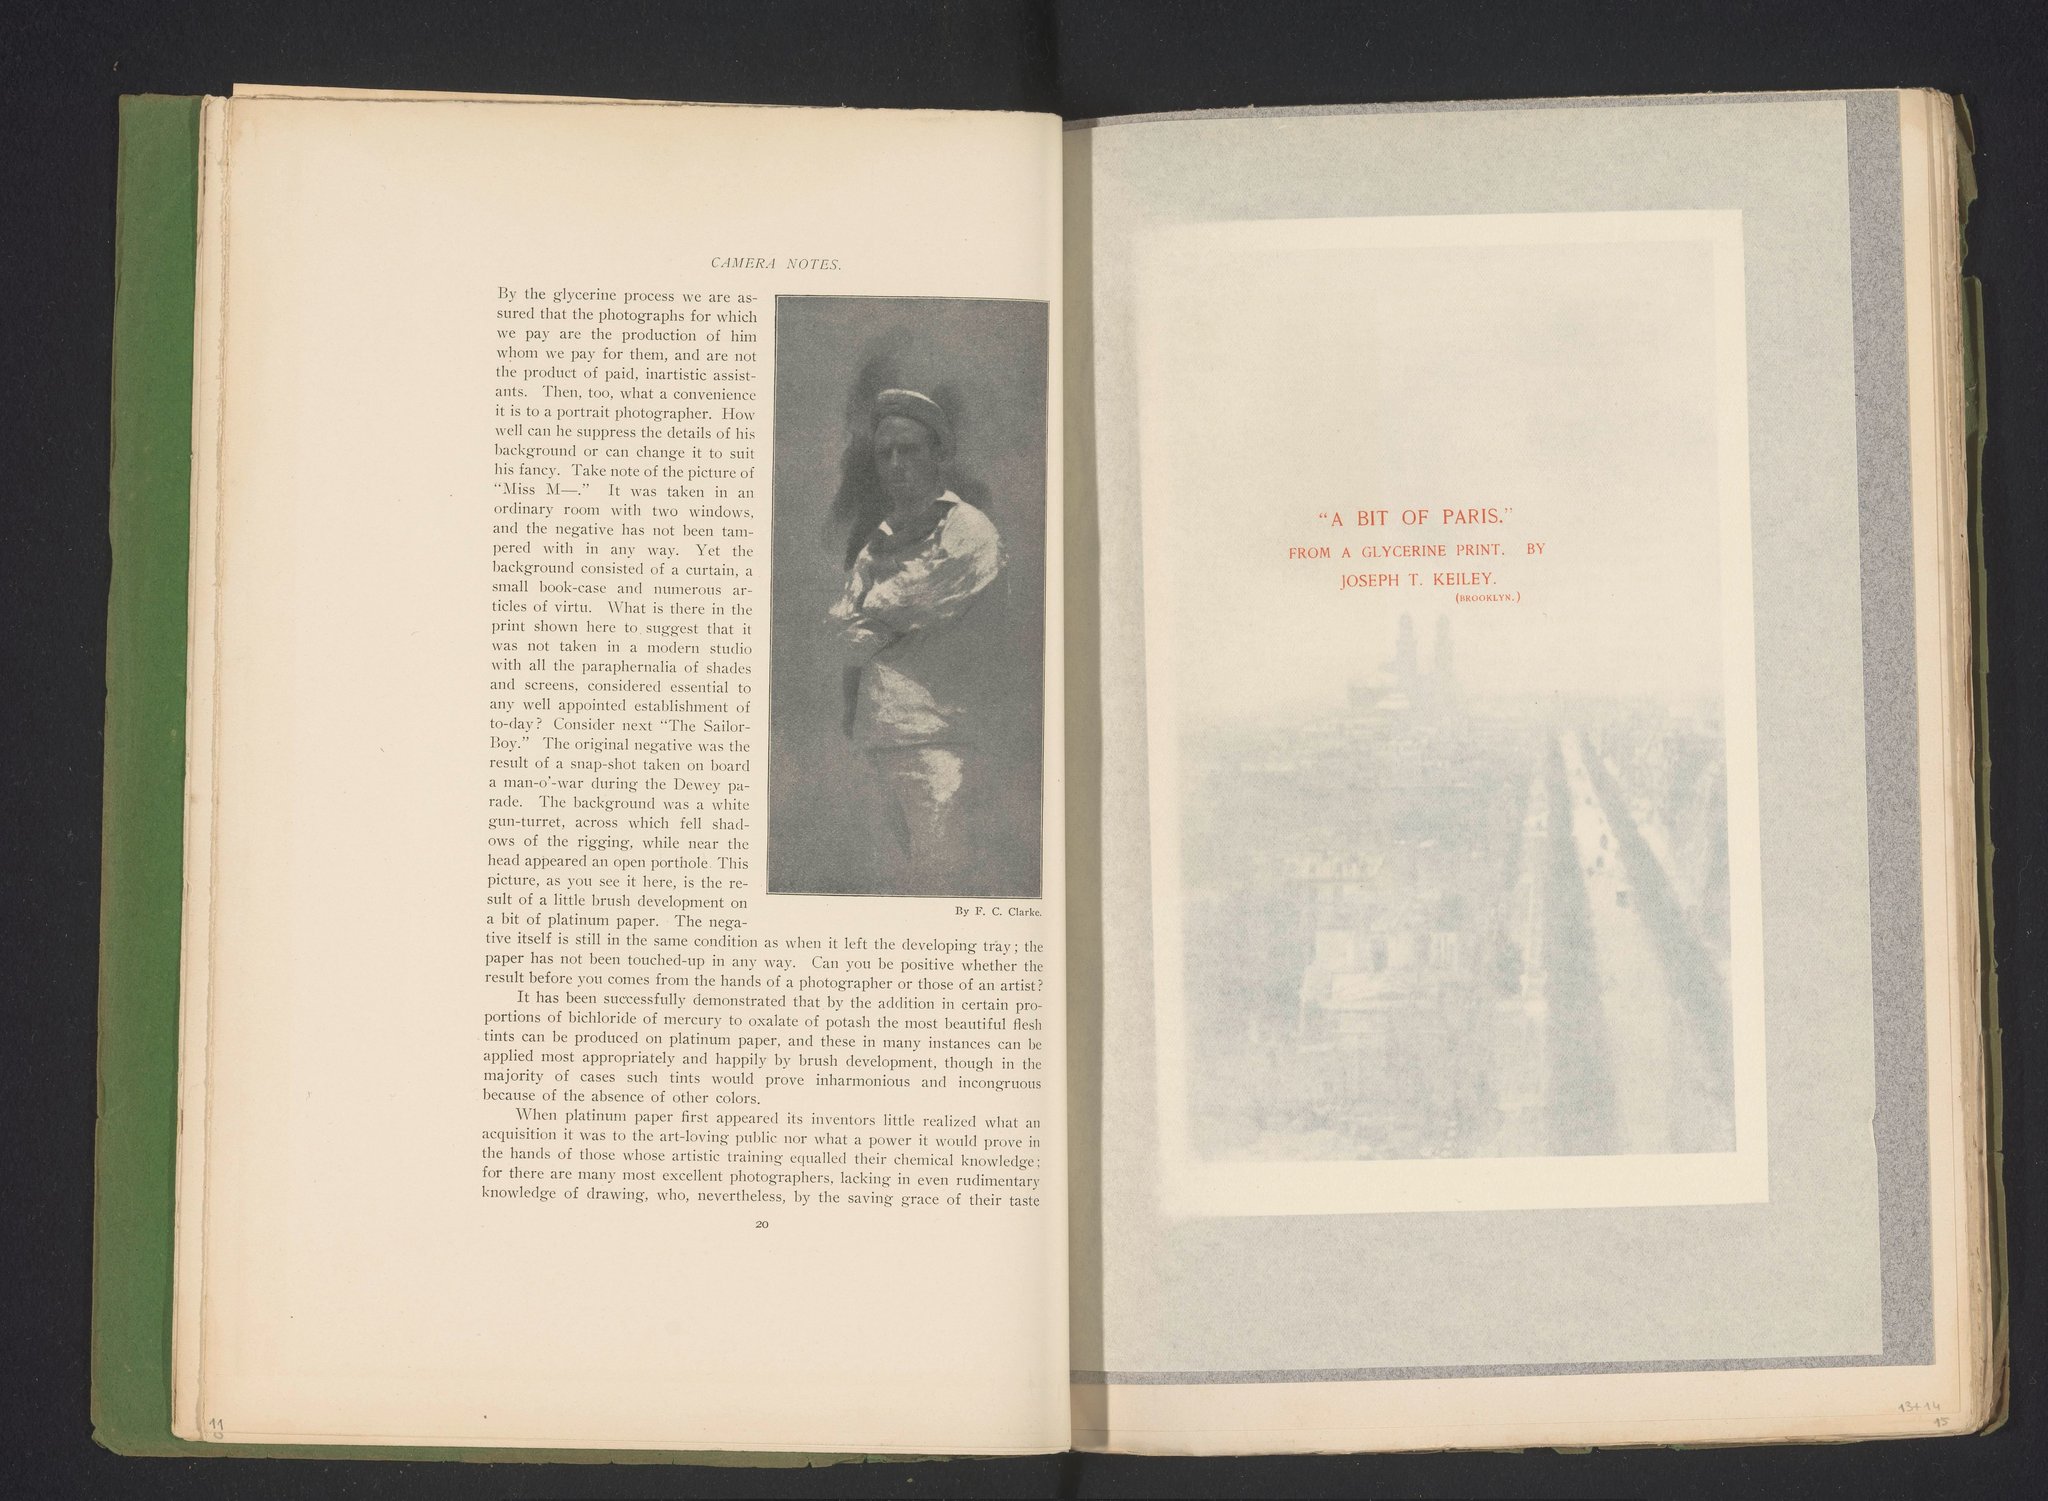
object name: photomechanical print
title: Portret van een onbekende matroos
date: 1896-1901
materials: paper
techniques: autotype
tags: seaman: sailor, historical persons not known by name